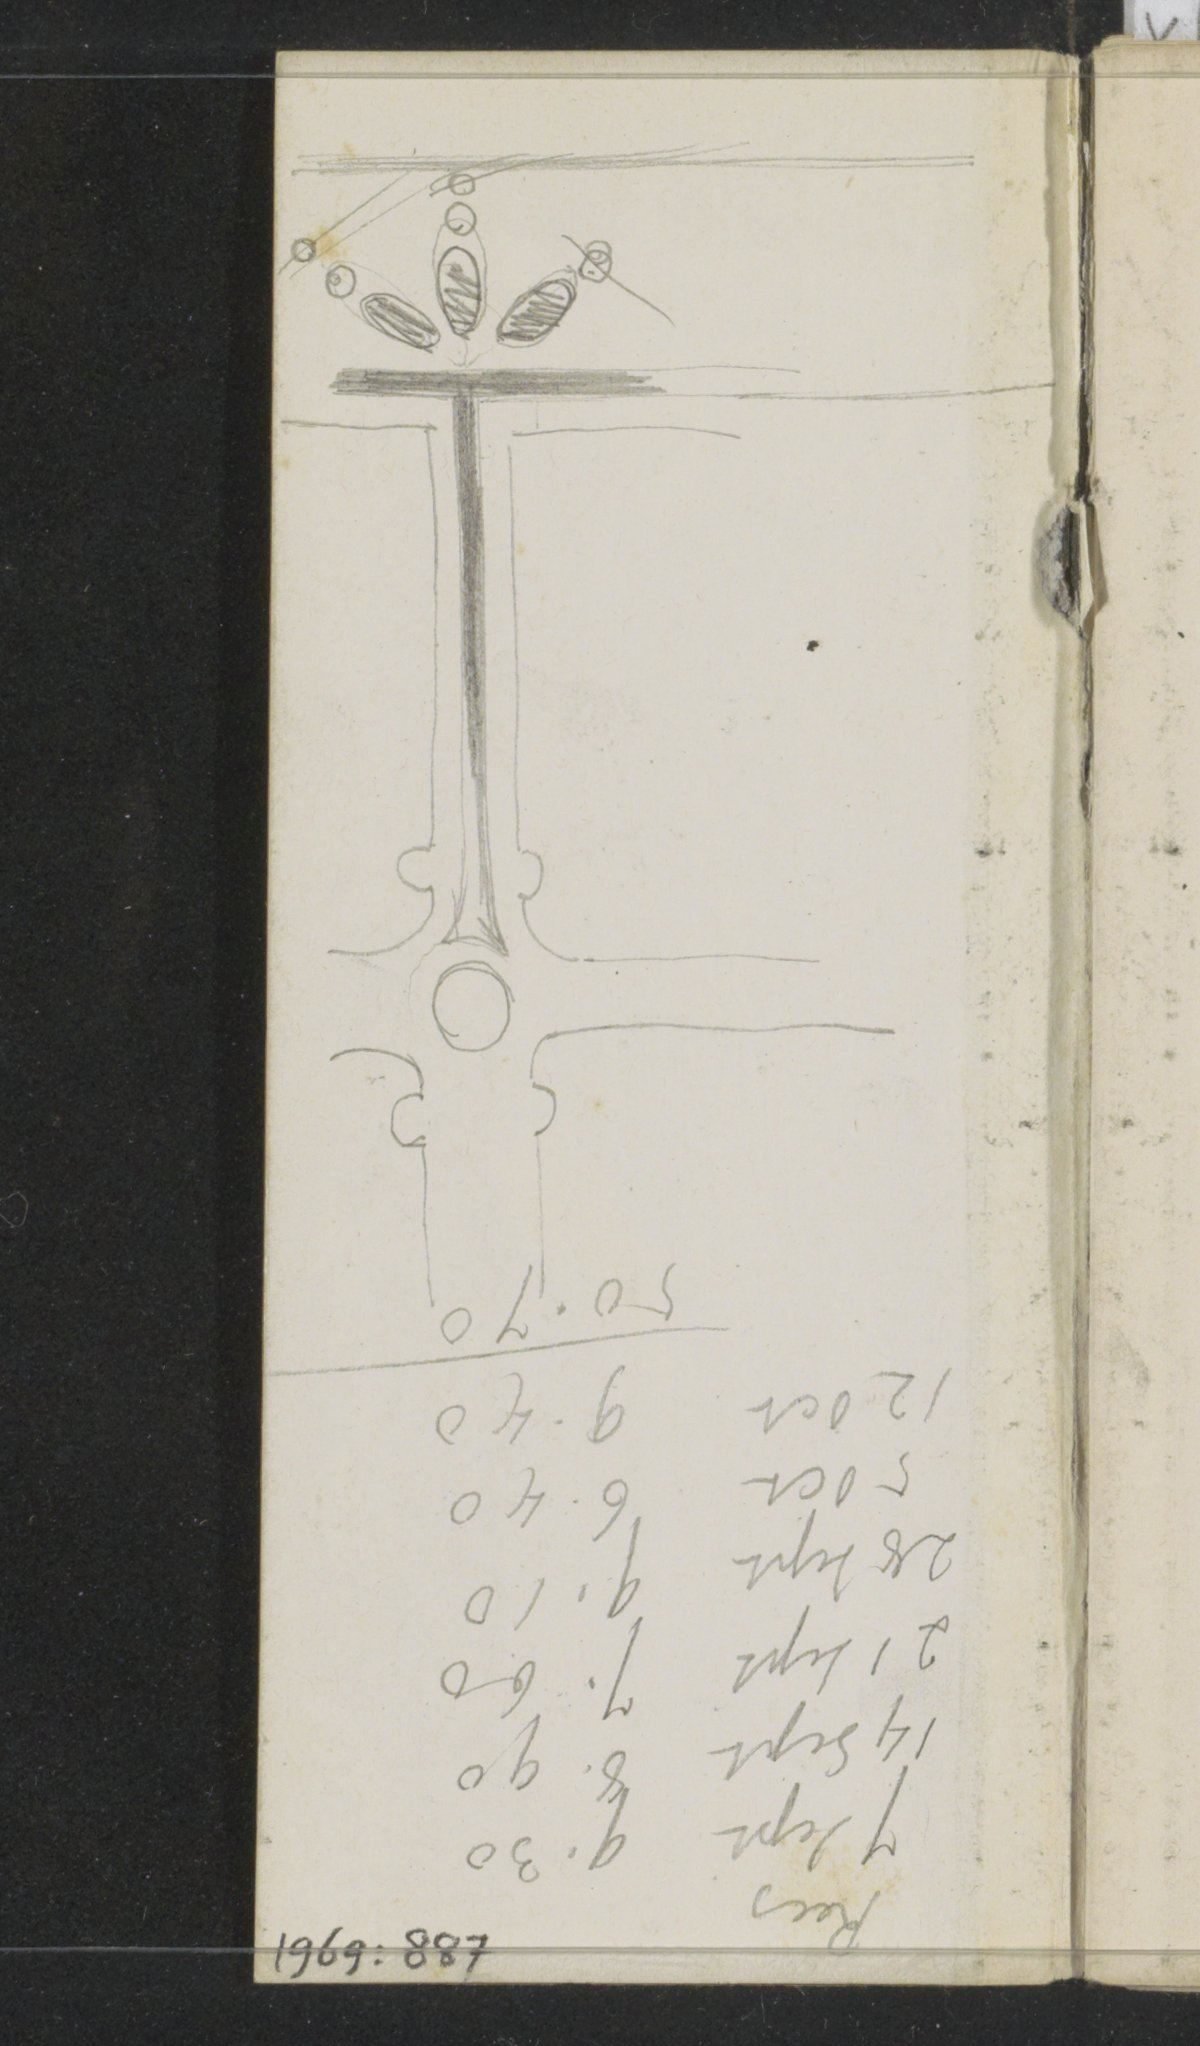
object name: endleaf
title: Ornament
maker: gerrit willem dijsselhof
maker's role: designer, draughtsman, print maker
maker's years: 1866-1924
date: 1876-1924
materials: paper, pencil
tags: ornaments ~ art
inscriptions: annotation: ‘Rees/ 7 sept 9.30/ 14 sept 8.90/ [...]’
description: Voorste schutblad uit een schetsboek met 24 bladen.